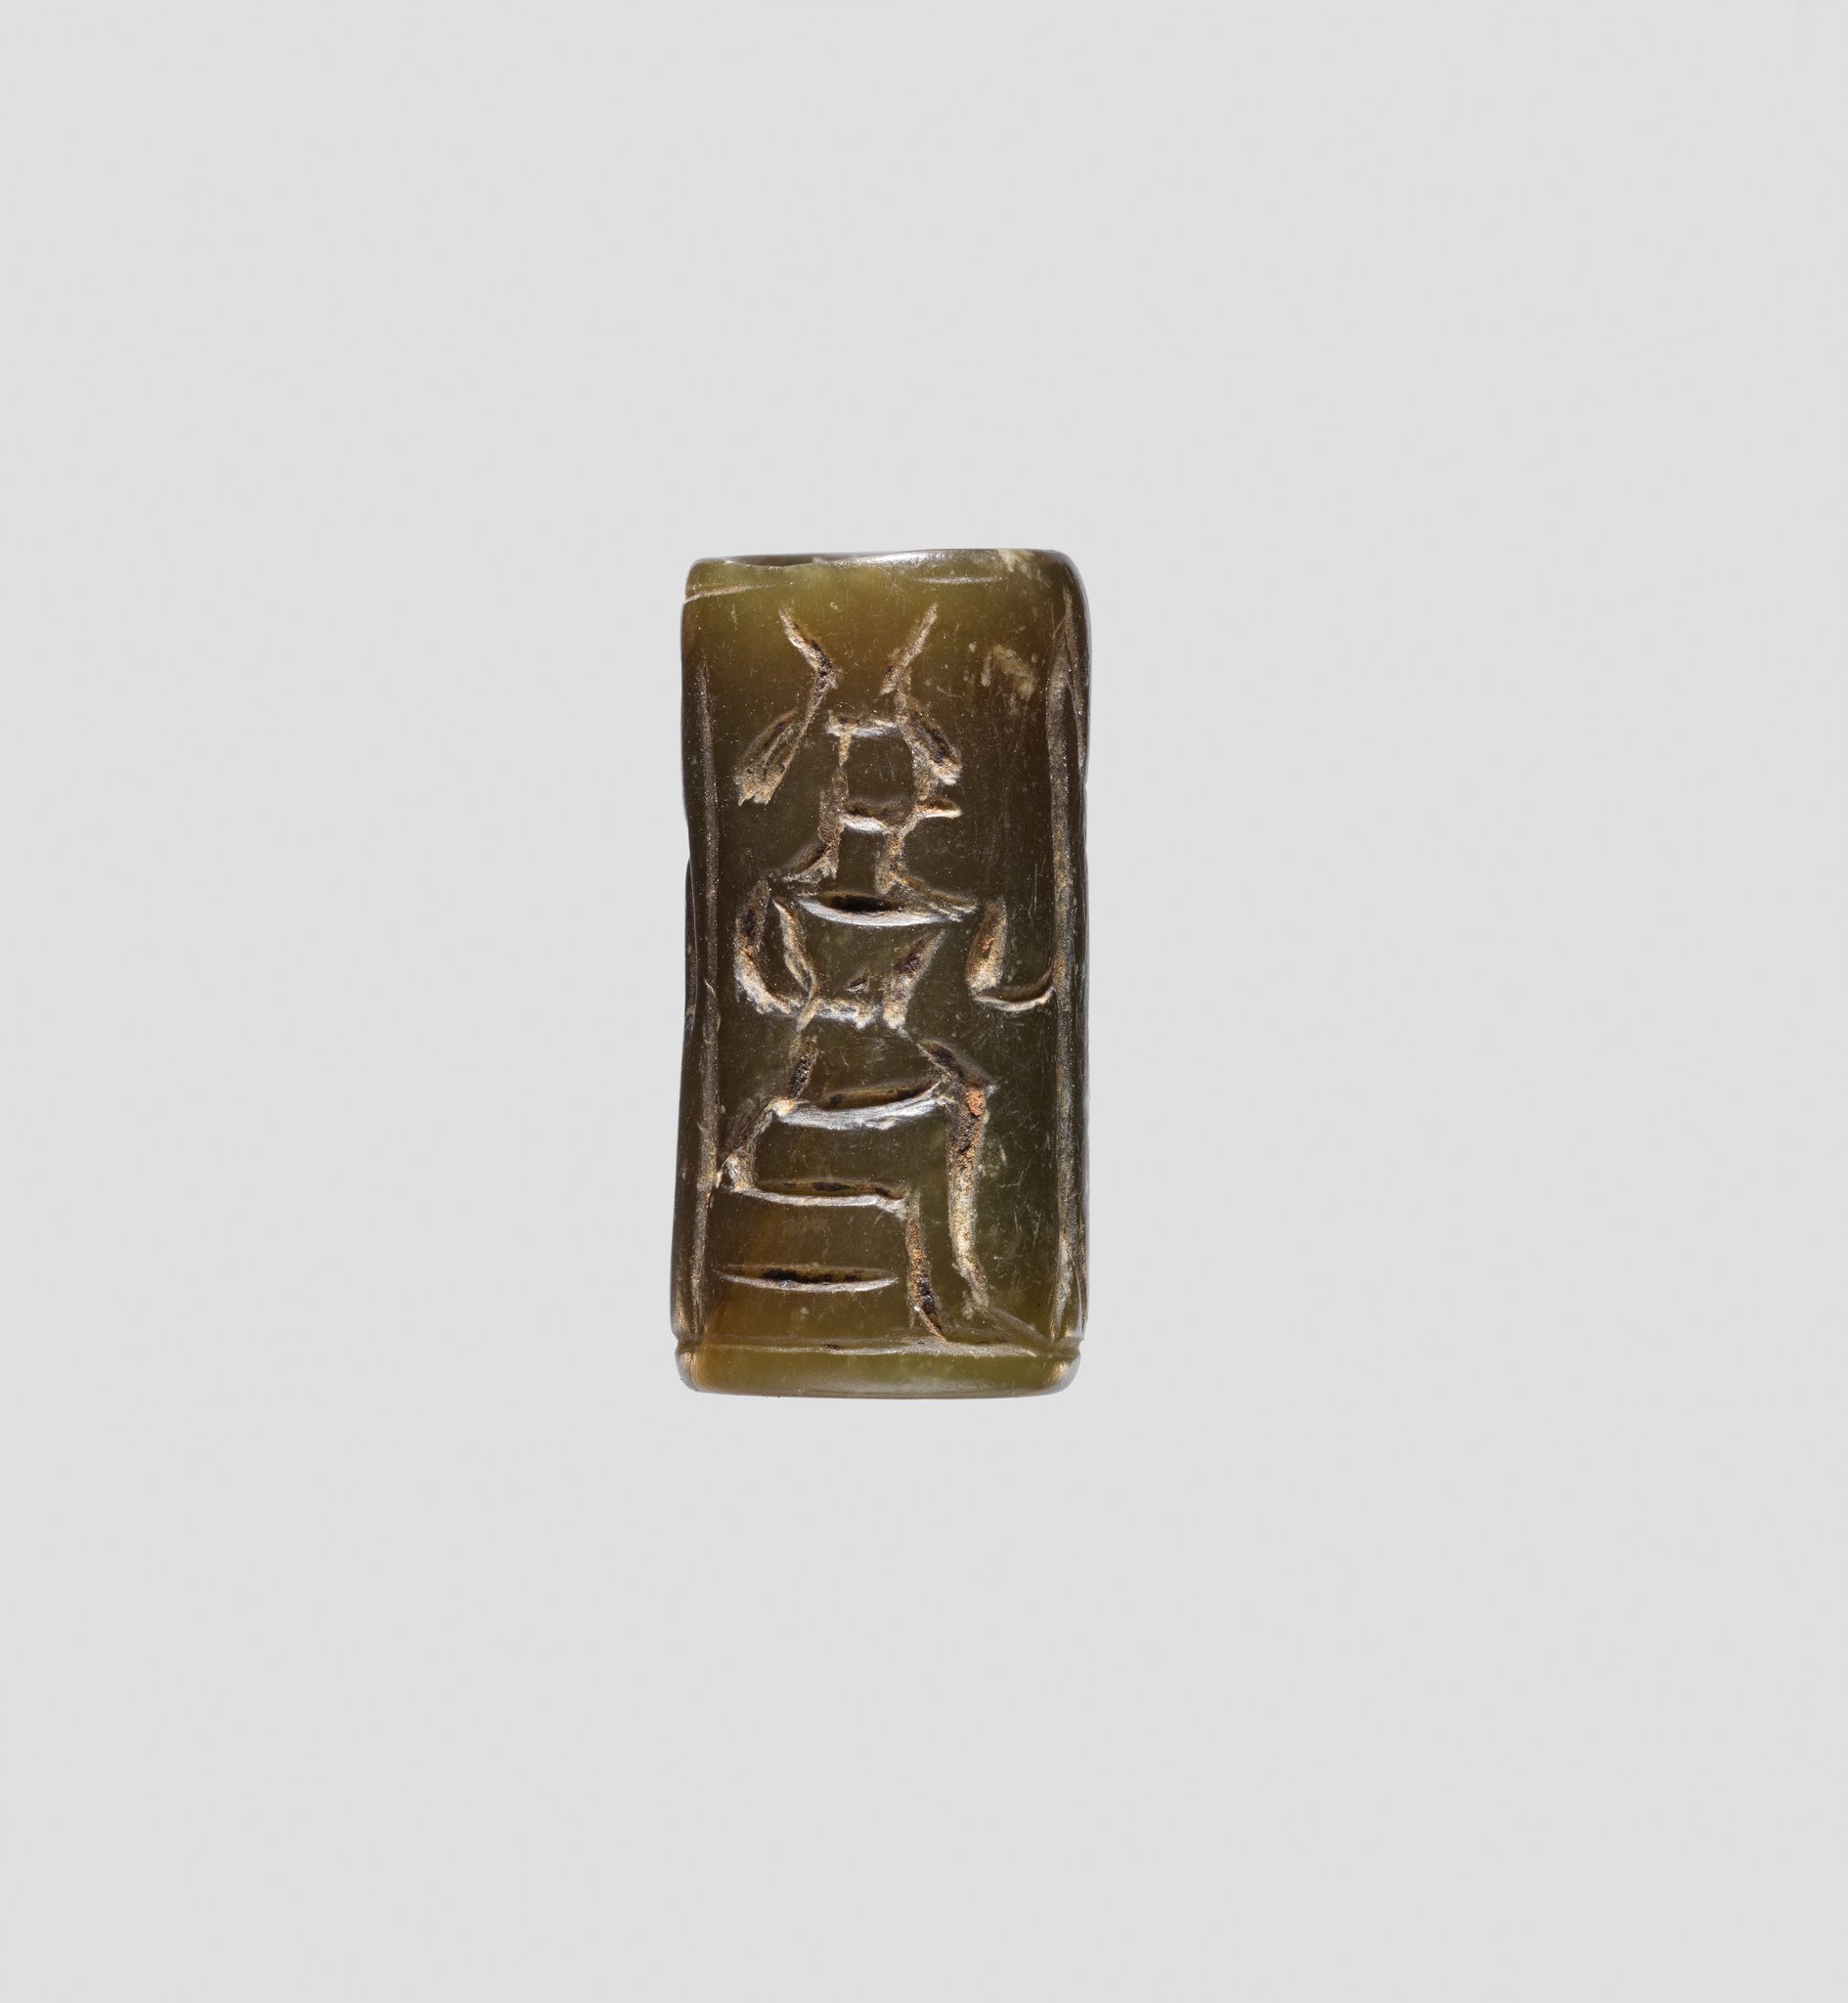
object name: cylinder seal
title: Cylinder seal with an image of seated Hathor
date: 2490-2472 BCE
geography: egypt